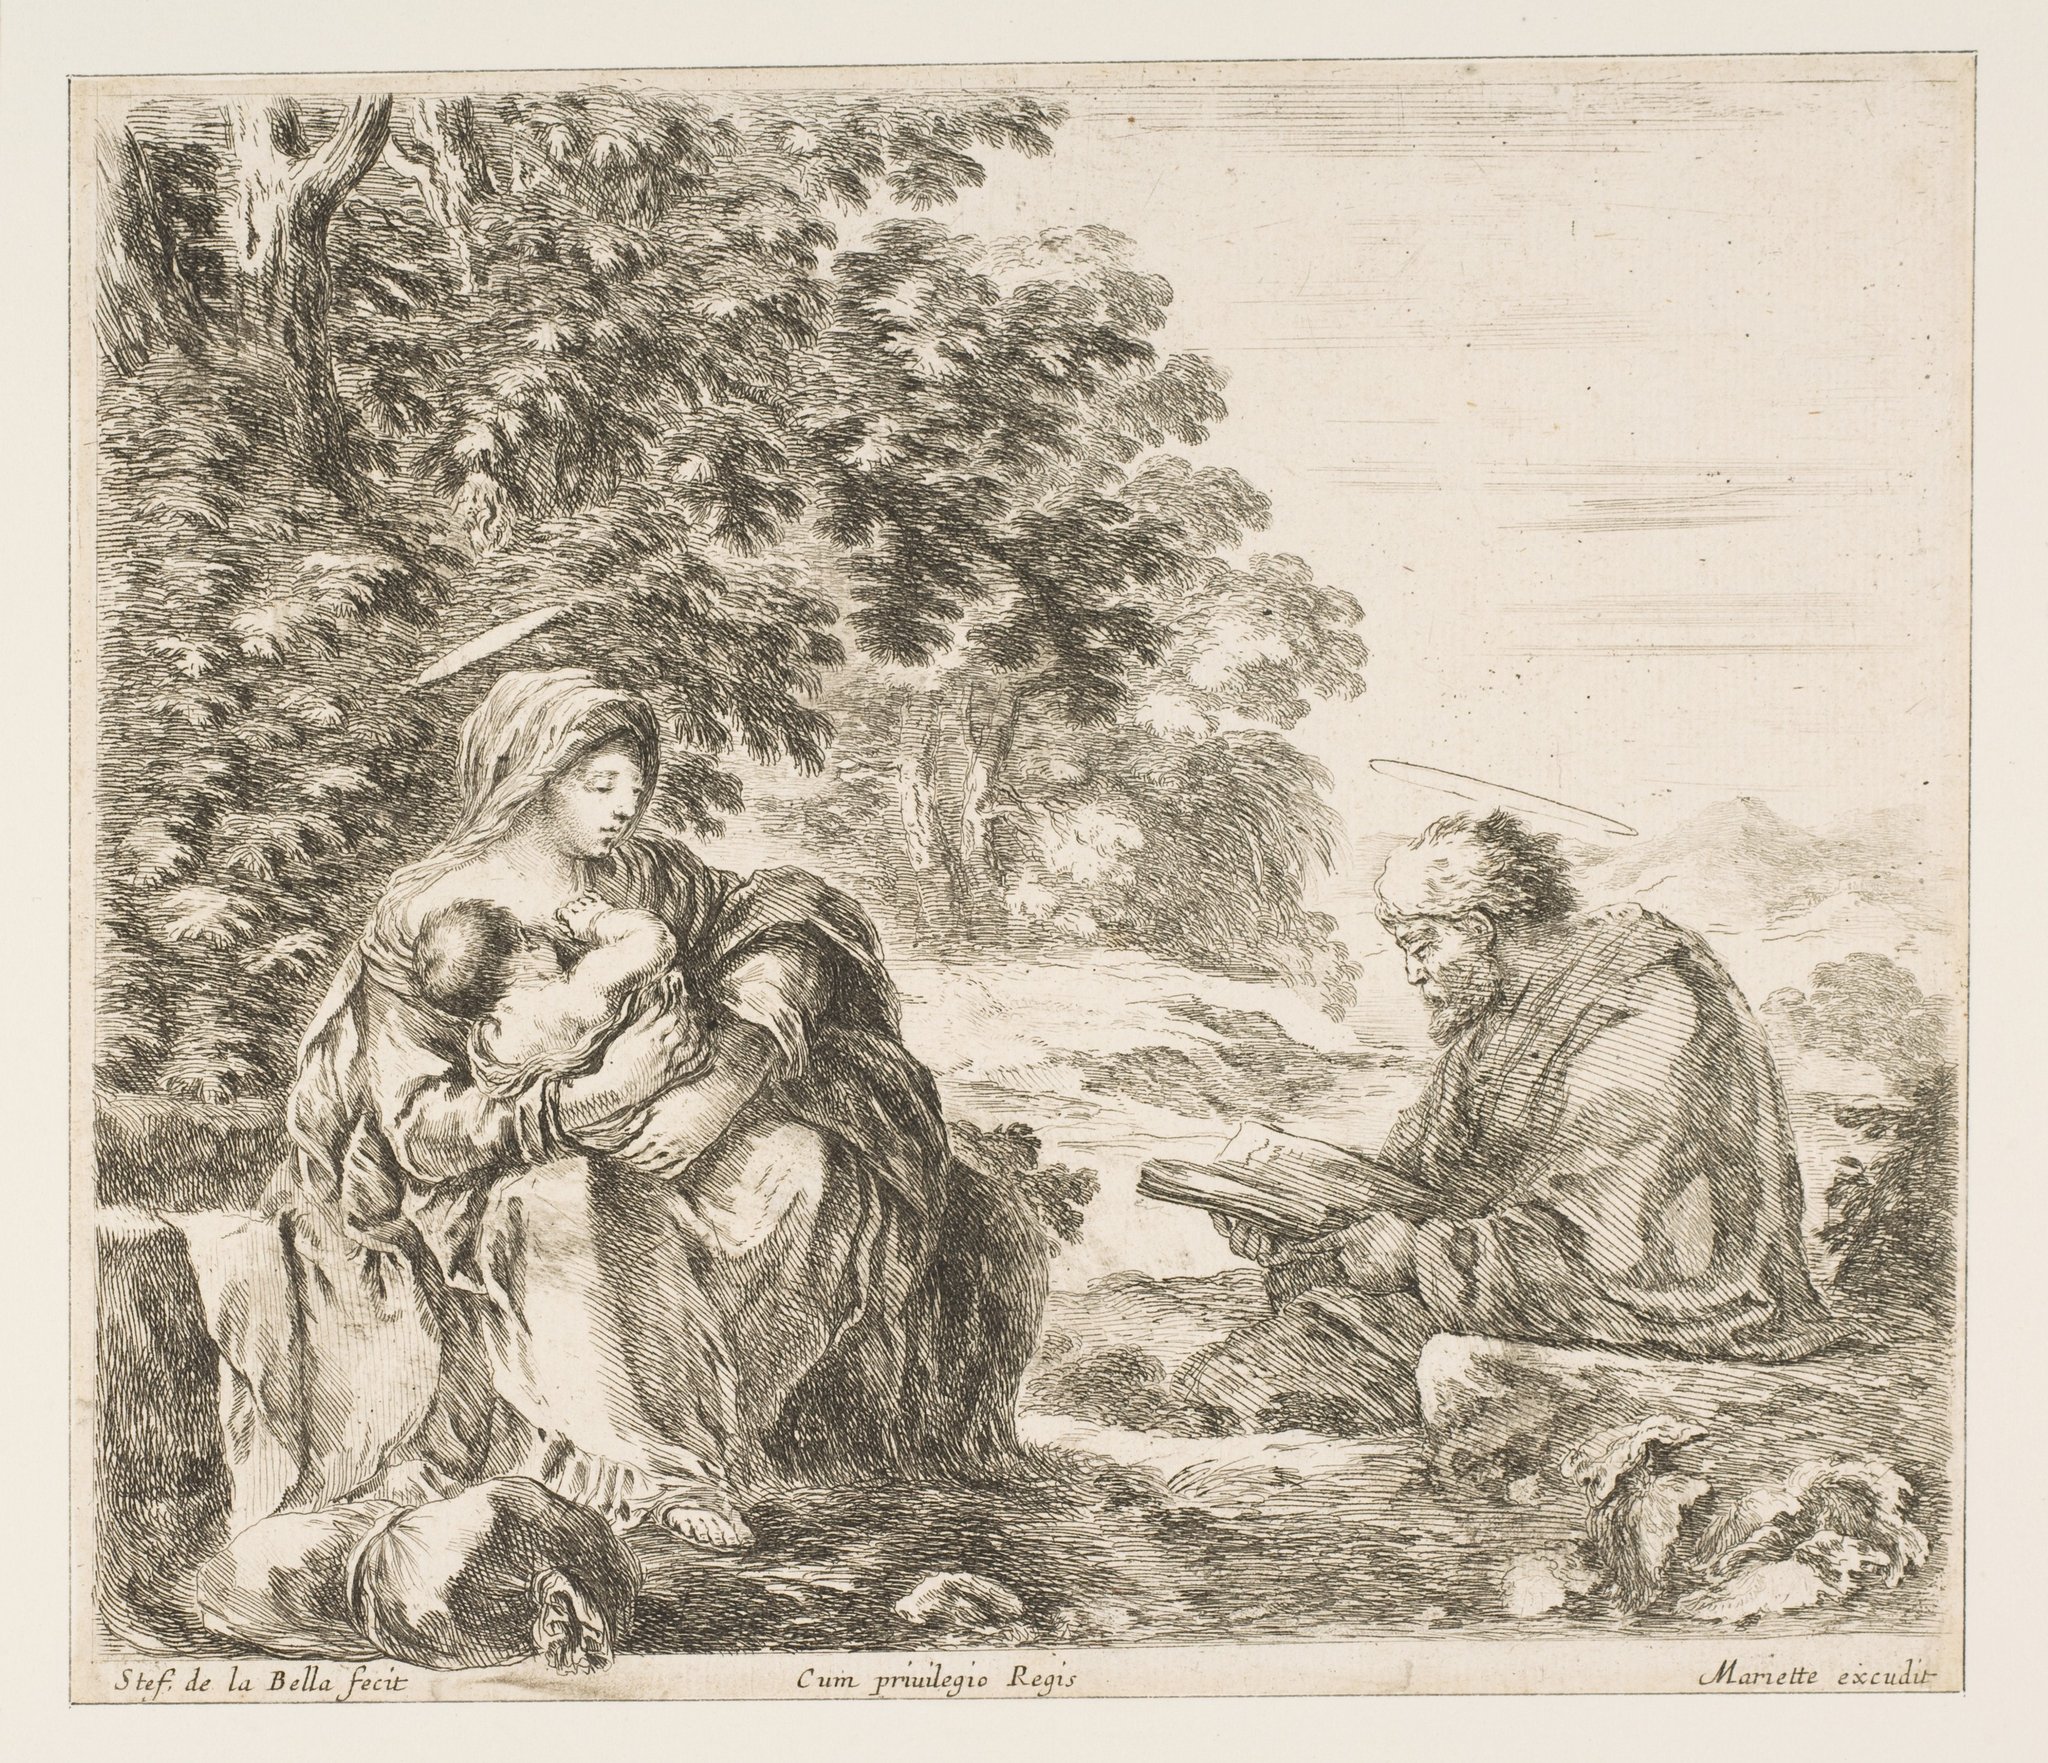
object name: print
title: Rest on the Flight into Egypt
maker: stefano della bella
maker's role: artist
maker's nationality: italian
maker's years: 1610-1664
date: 1649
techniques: etching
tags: men,christ,virgin mary